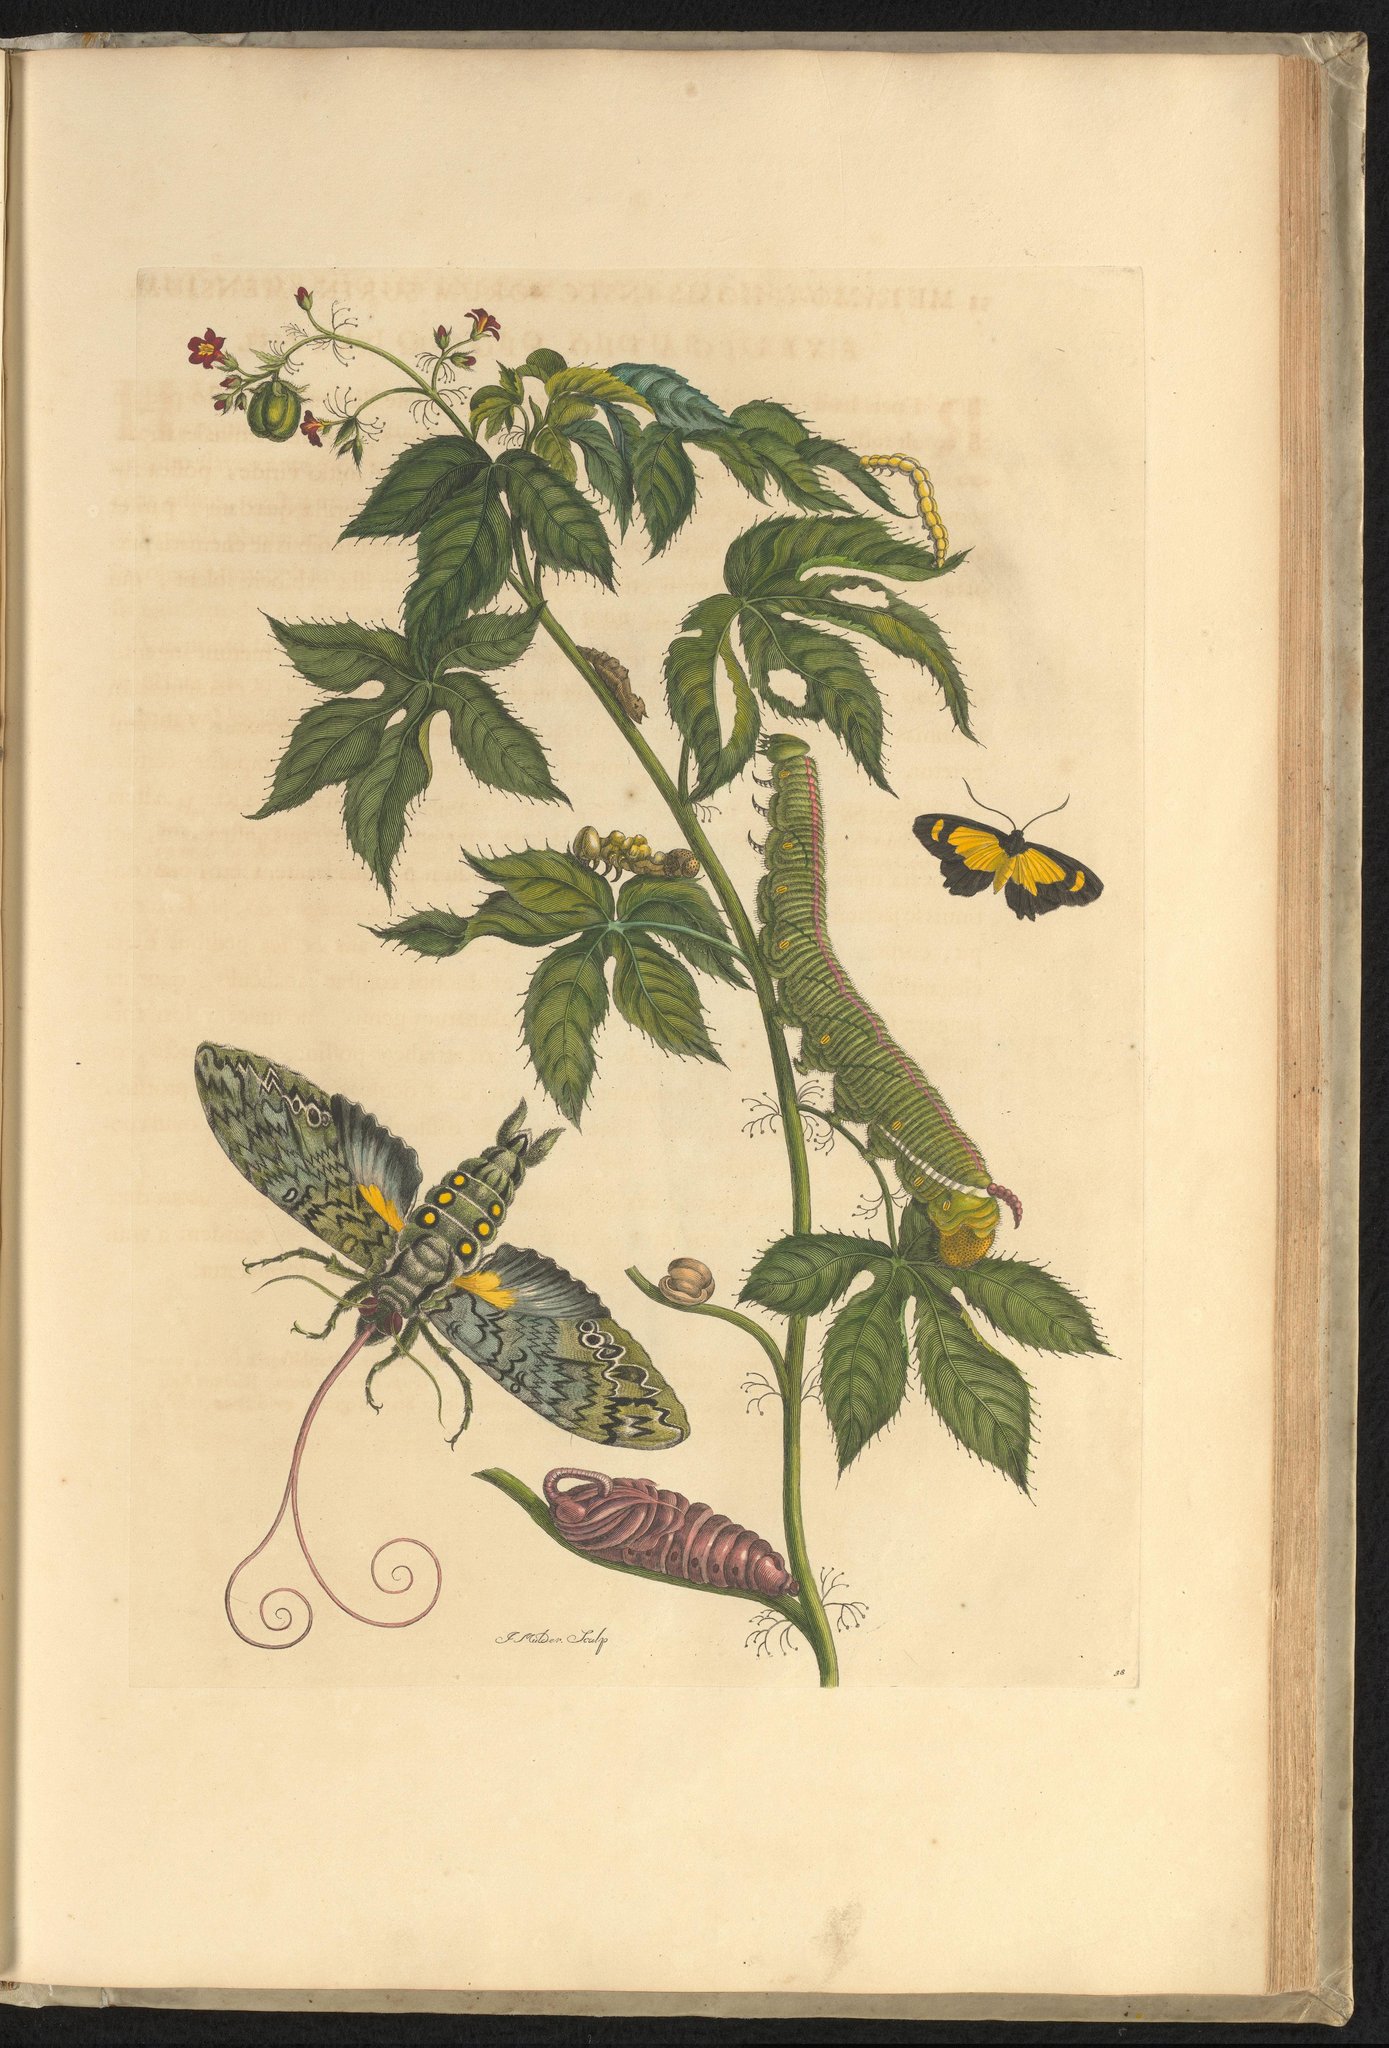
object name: page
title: Rode schijtnoten (Jatropha gossypiifolia) met vlinder, nachtvlinder en andere insecten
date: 1705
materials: paper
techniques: etching, hand coloring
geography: amsterdam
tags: insects: pupa, insects: moth, insects: butterfly, insects: caterpillar, plants and herbs, suriname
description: Rechtsonder genummerd: 38. Prent maakt deel uit van een boek.